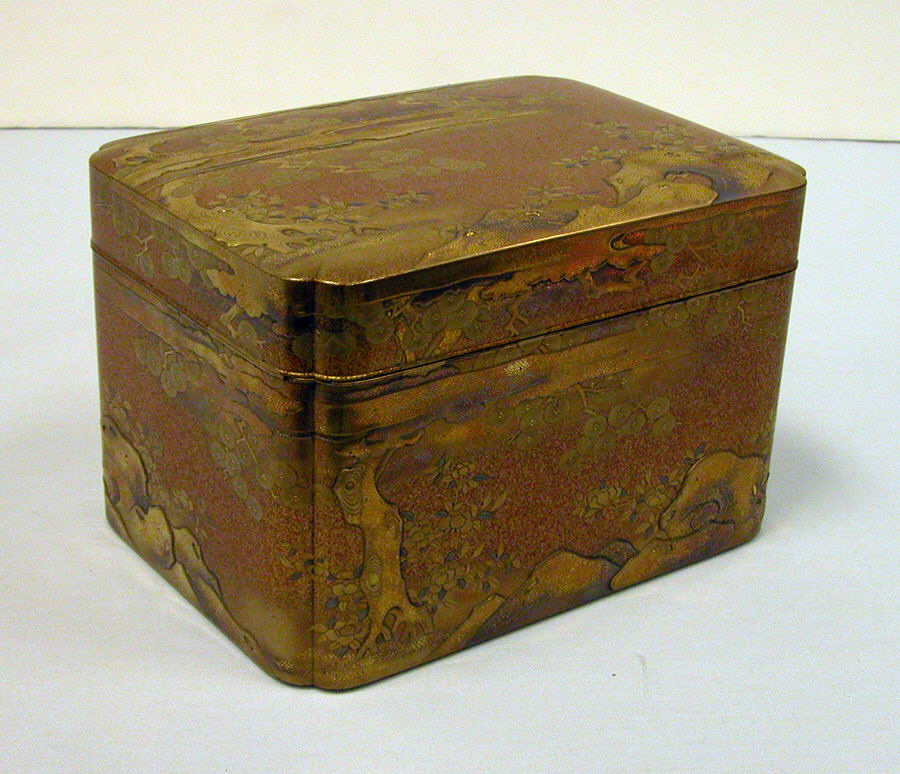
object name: box with tray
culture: japanese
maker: higashiyawa yohimasa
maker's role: artist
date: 1601-1700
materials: gold, lacquer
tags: trees